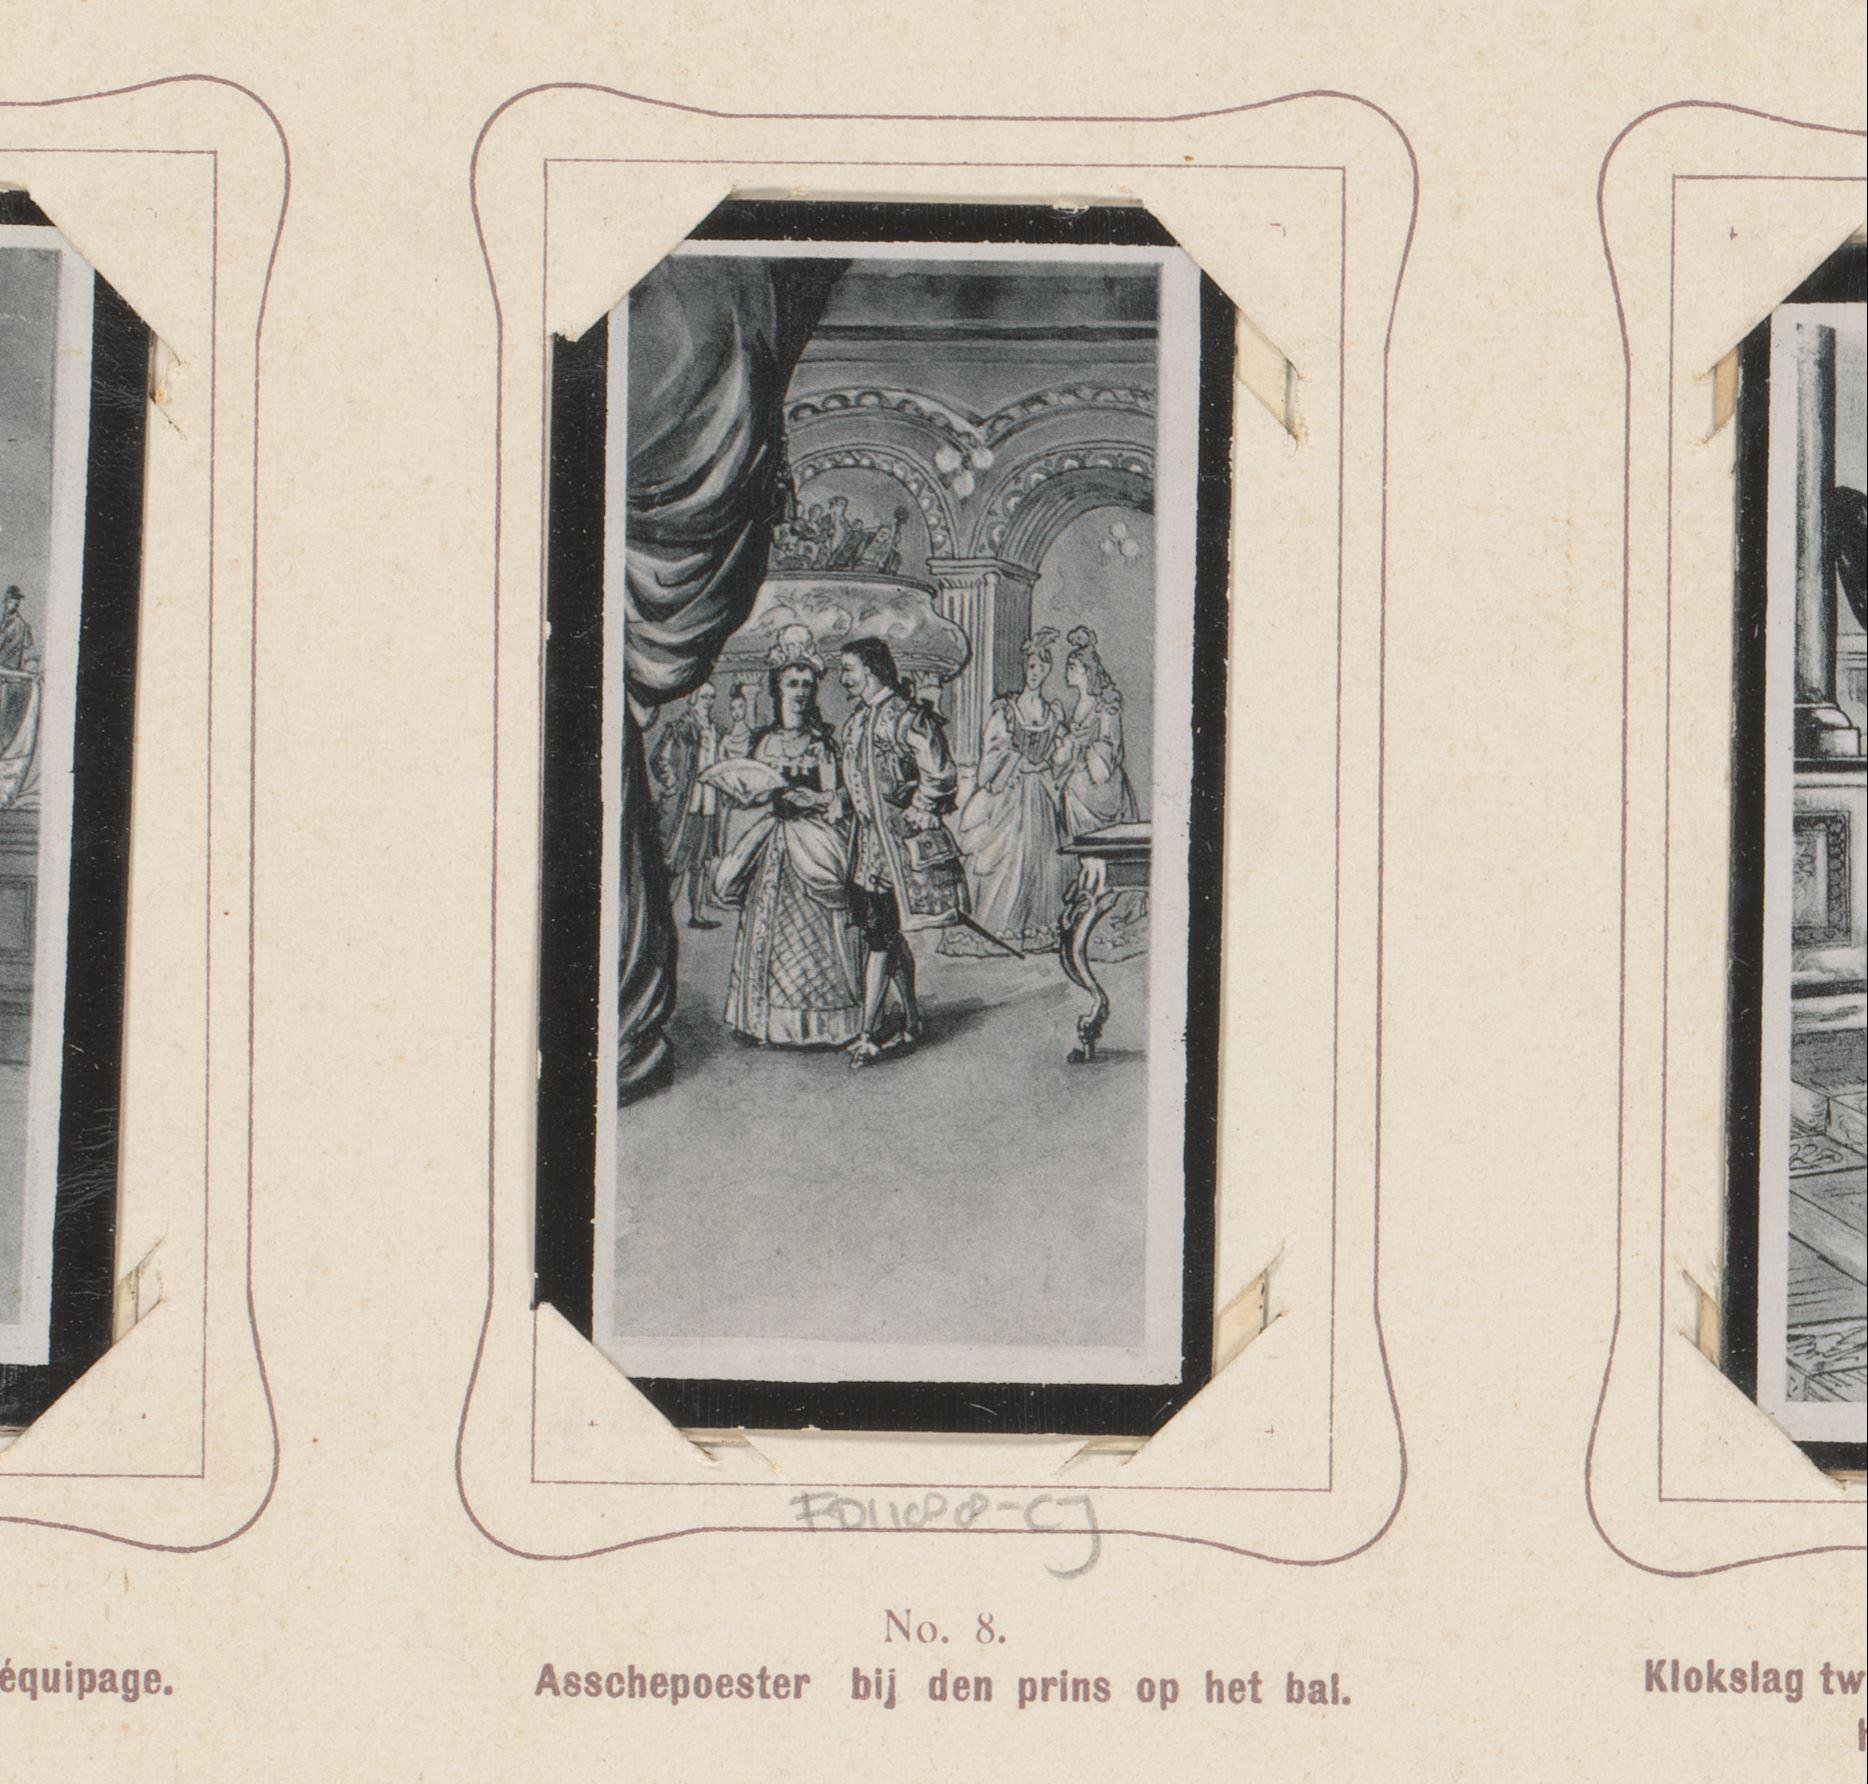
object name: photomechanical print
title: Reproductie van een tekening van Assepoester met de prins op het bal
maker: Anonymous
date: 1906-1907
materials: paper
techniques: photograph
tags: tales and fairy tales (with title)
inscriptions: inscription: ‘No. 8./ Asschepoester bij den prins op het bal.’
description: Deze prent maakt deel uit van een album.